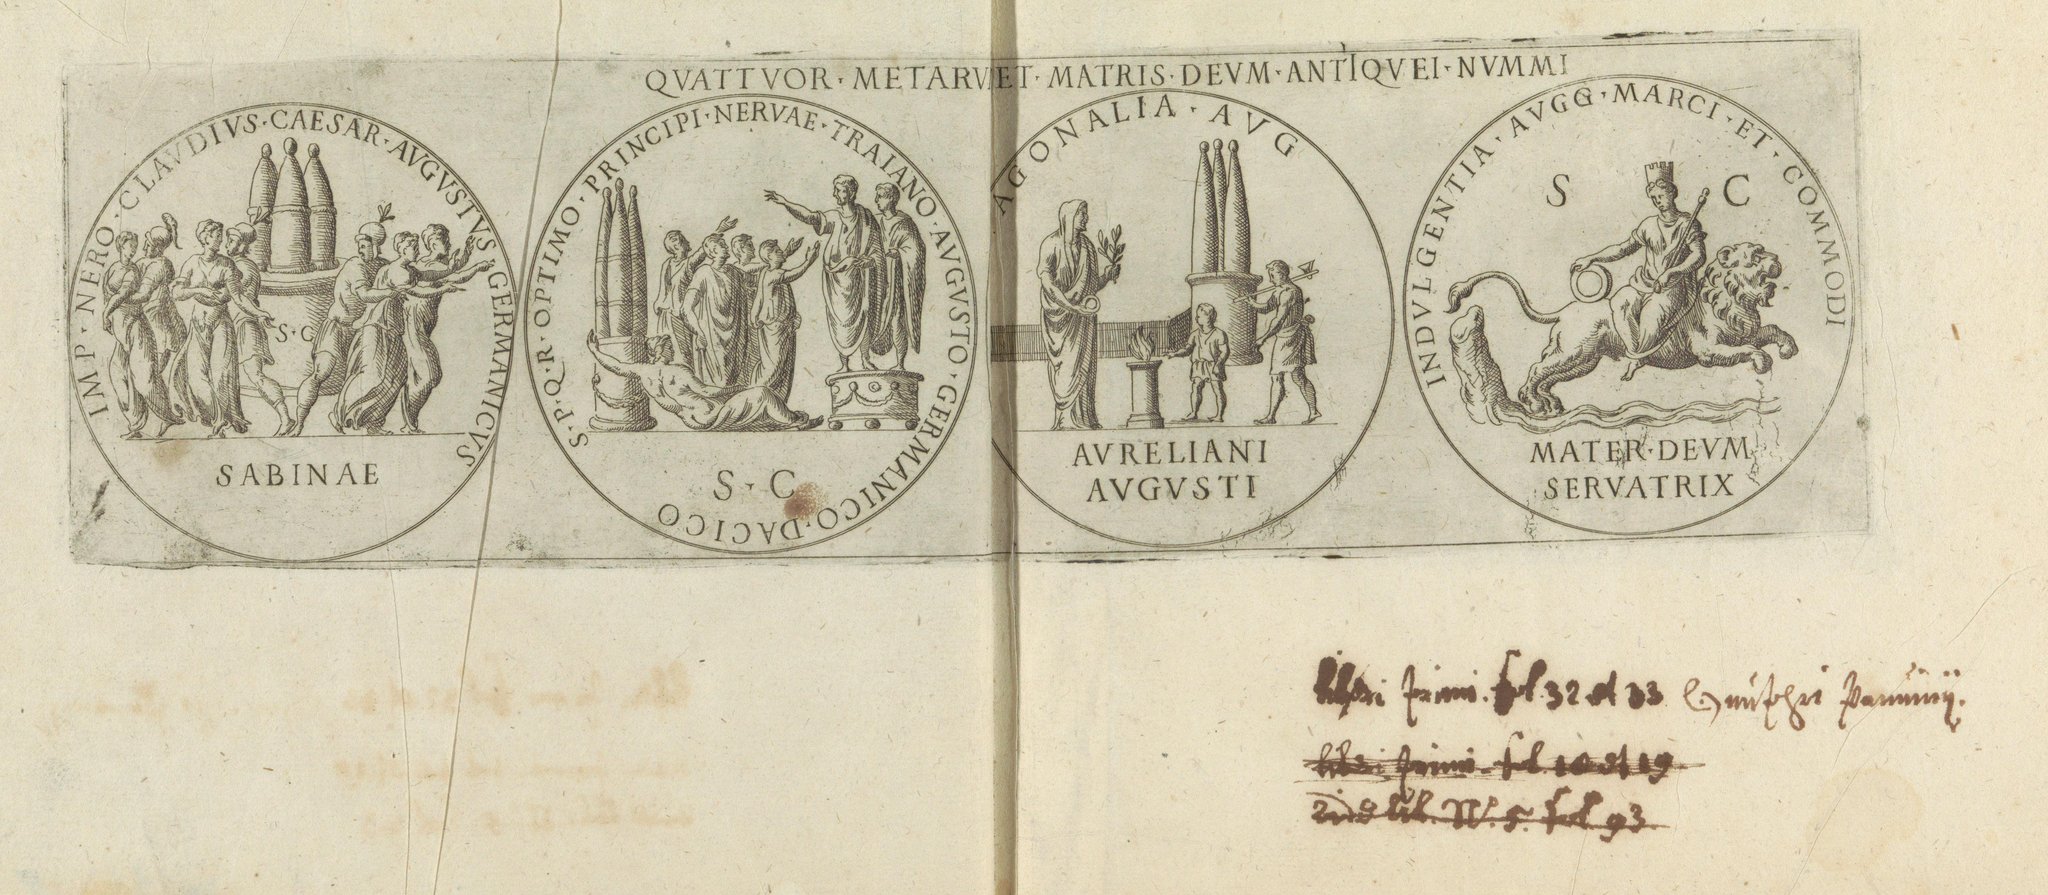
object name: print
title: Vier penningen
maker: onofrio panvinio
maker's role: priest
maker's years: 1530-1568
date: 1580-1600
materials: paper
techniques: etching, intaglio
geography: italy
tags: city-crown, mural crown, rape of the sabine women: they are carried off by romulus and his men during a feast, coin, beasts of prey, predatory animals: lion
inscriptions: inscription: ‘libri [...] fol. 18 - 19 [...] lib. vol. 5. fol. 93/ [...] fol. 32 - 33 [...]’, number: ‘29’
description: Deze prent is gebruikt voor de publicatie: Panvinio, Onofrio. De Ludis Circensibus. Venetië: Giovanni Battista Ciotti, 1600.